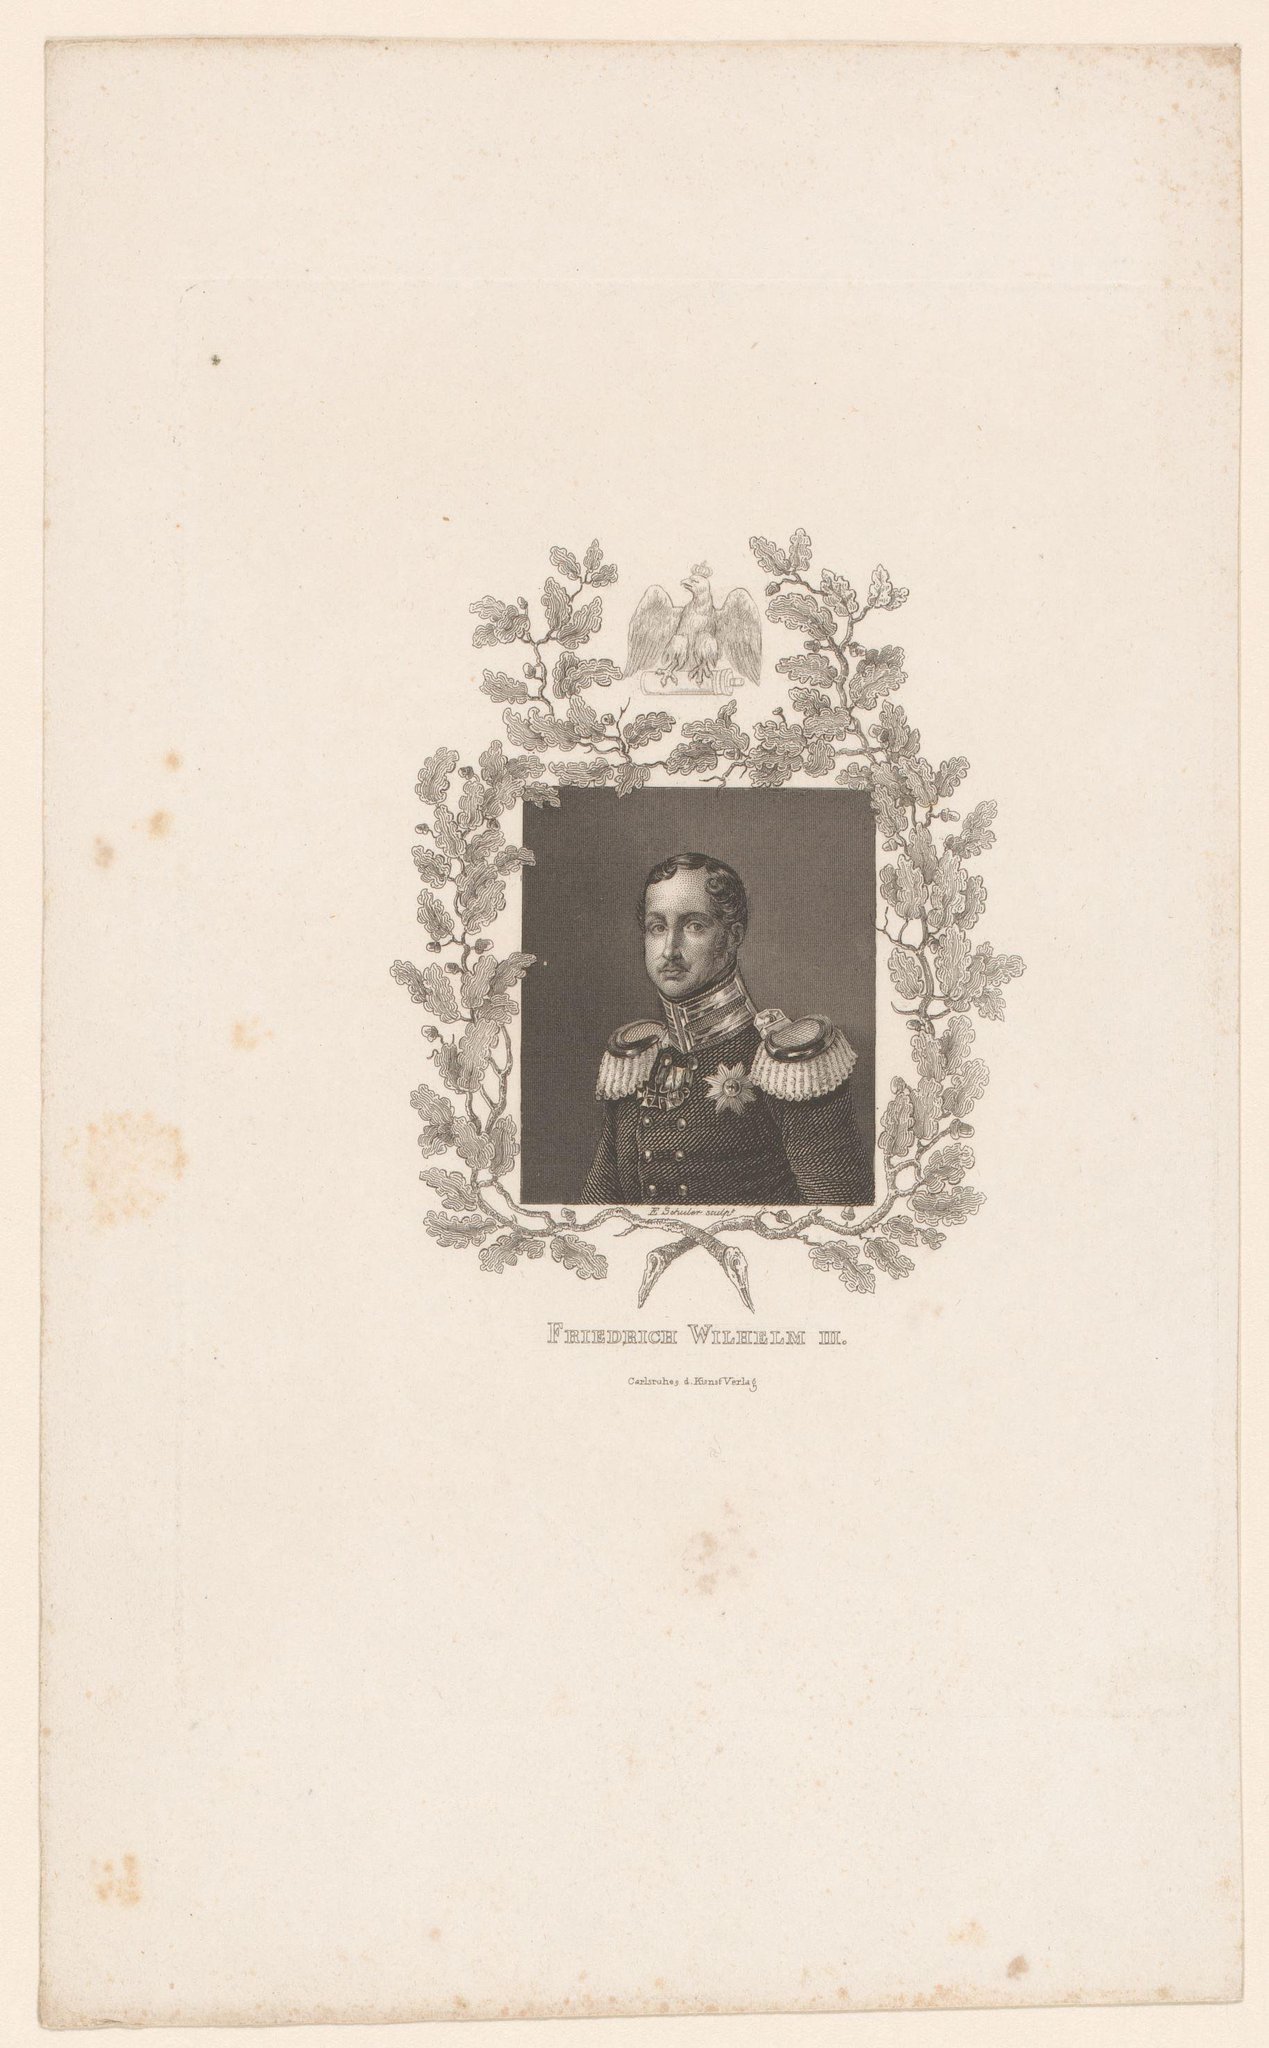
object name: print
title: Portret van Friedrich Wilhelm III van Pruisen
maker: edouard schuler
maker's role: print maker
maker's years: 1806-1882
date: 1816-1882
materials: paper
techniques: engraving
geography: karlsruhe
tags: berlin, frederik willem iii koning van pruisen, historical persons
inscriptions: collector's mark: Lugt 2228